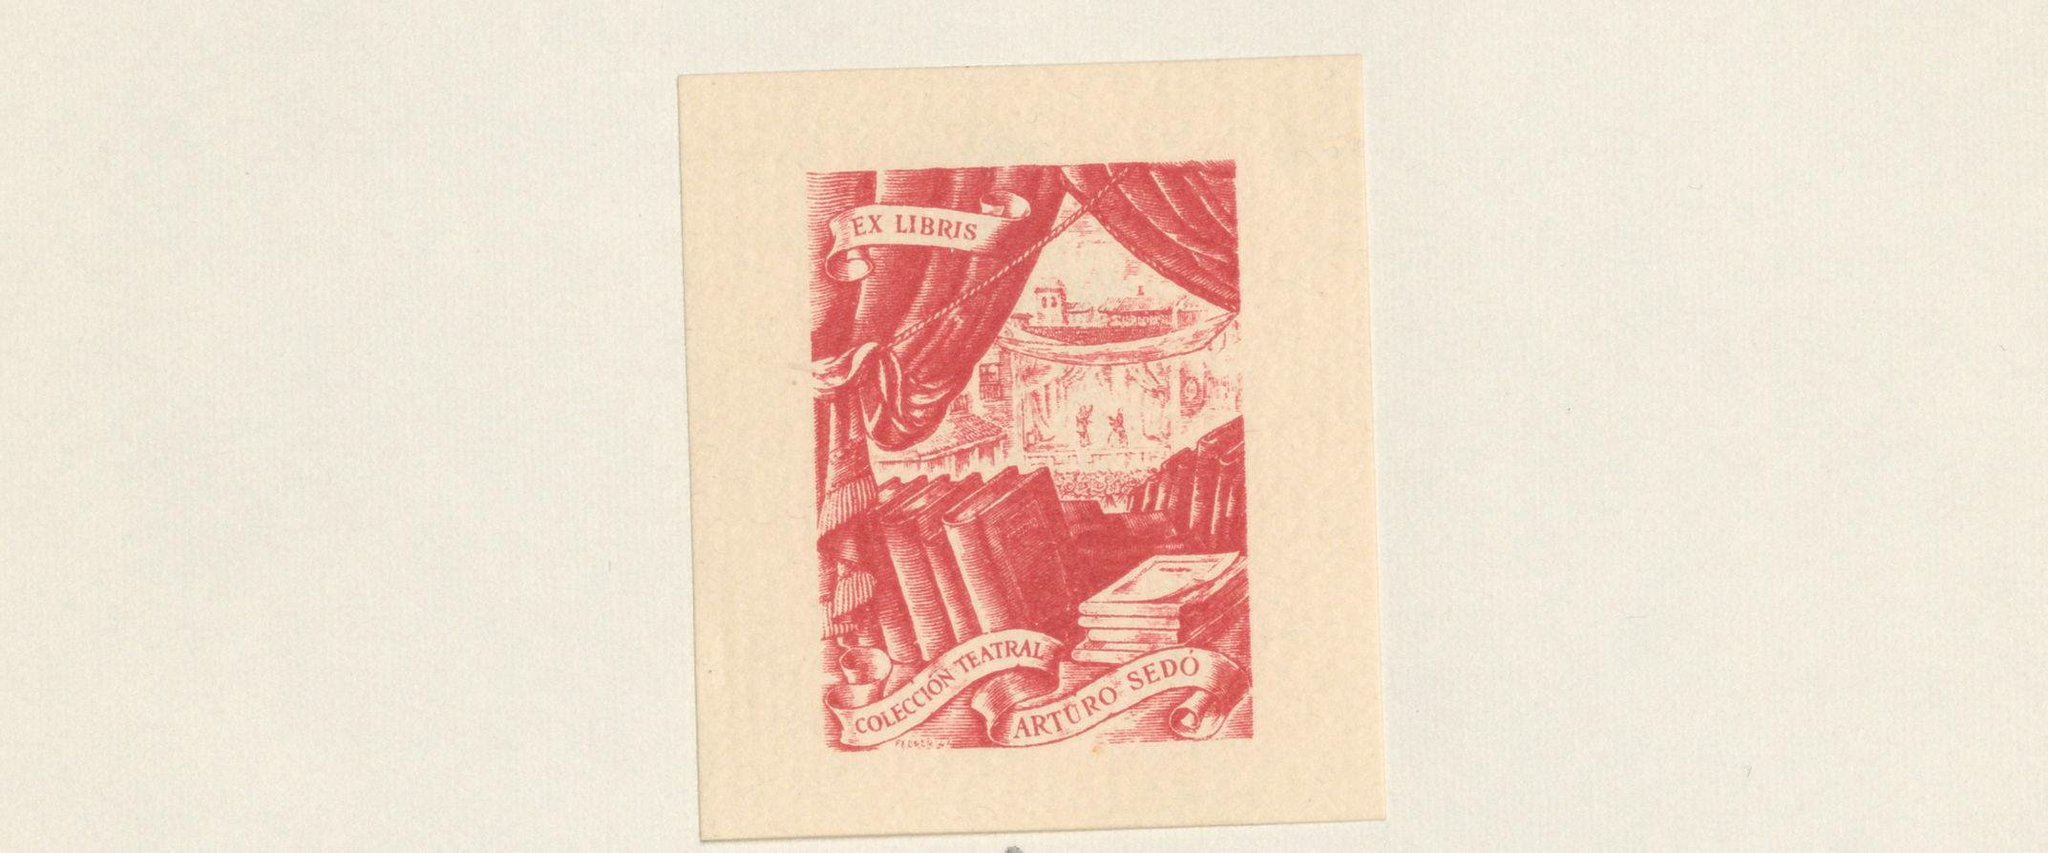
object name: bookplate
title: Ex libris van Juan Arturo Sedó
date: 1900-1949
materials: paper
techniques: printing block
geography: spain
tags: set, scenery ~ stage, book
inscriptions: collector's mark: ‘Coleccion Juan Arturo Sedó/ Duplicado’